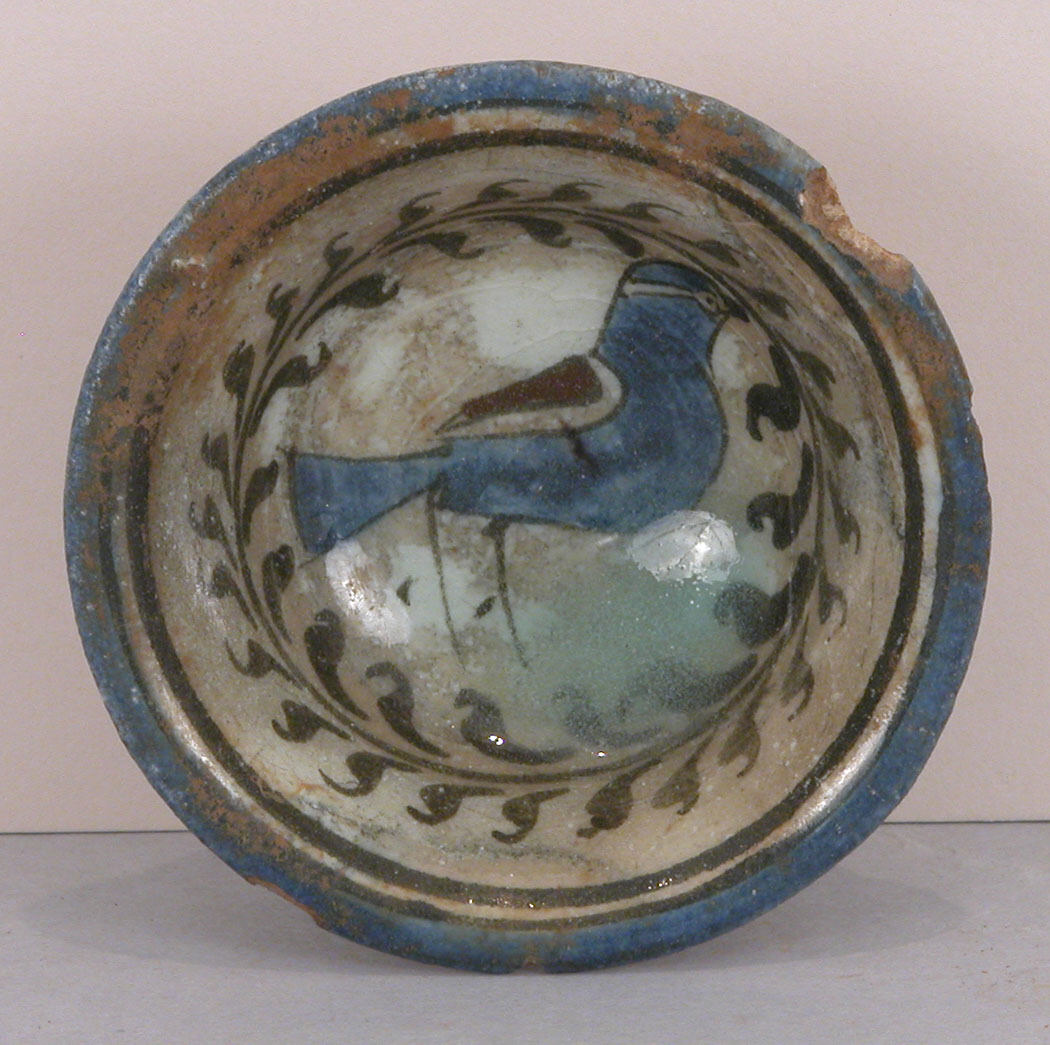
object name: bowl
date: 1101-1300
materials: glaze, stonepaste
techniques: painting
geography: syria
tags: birds